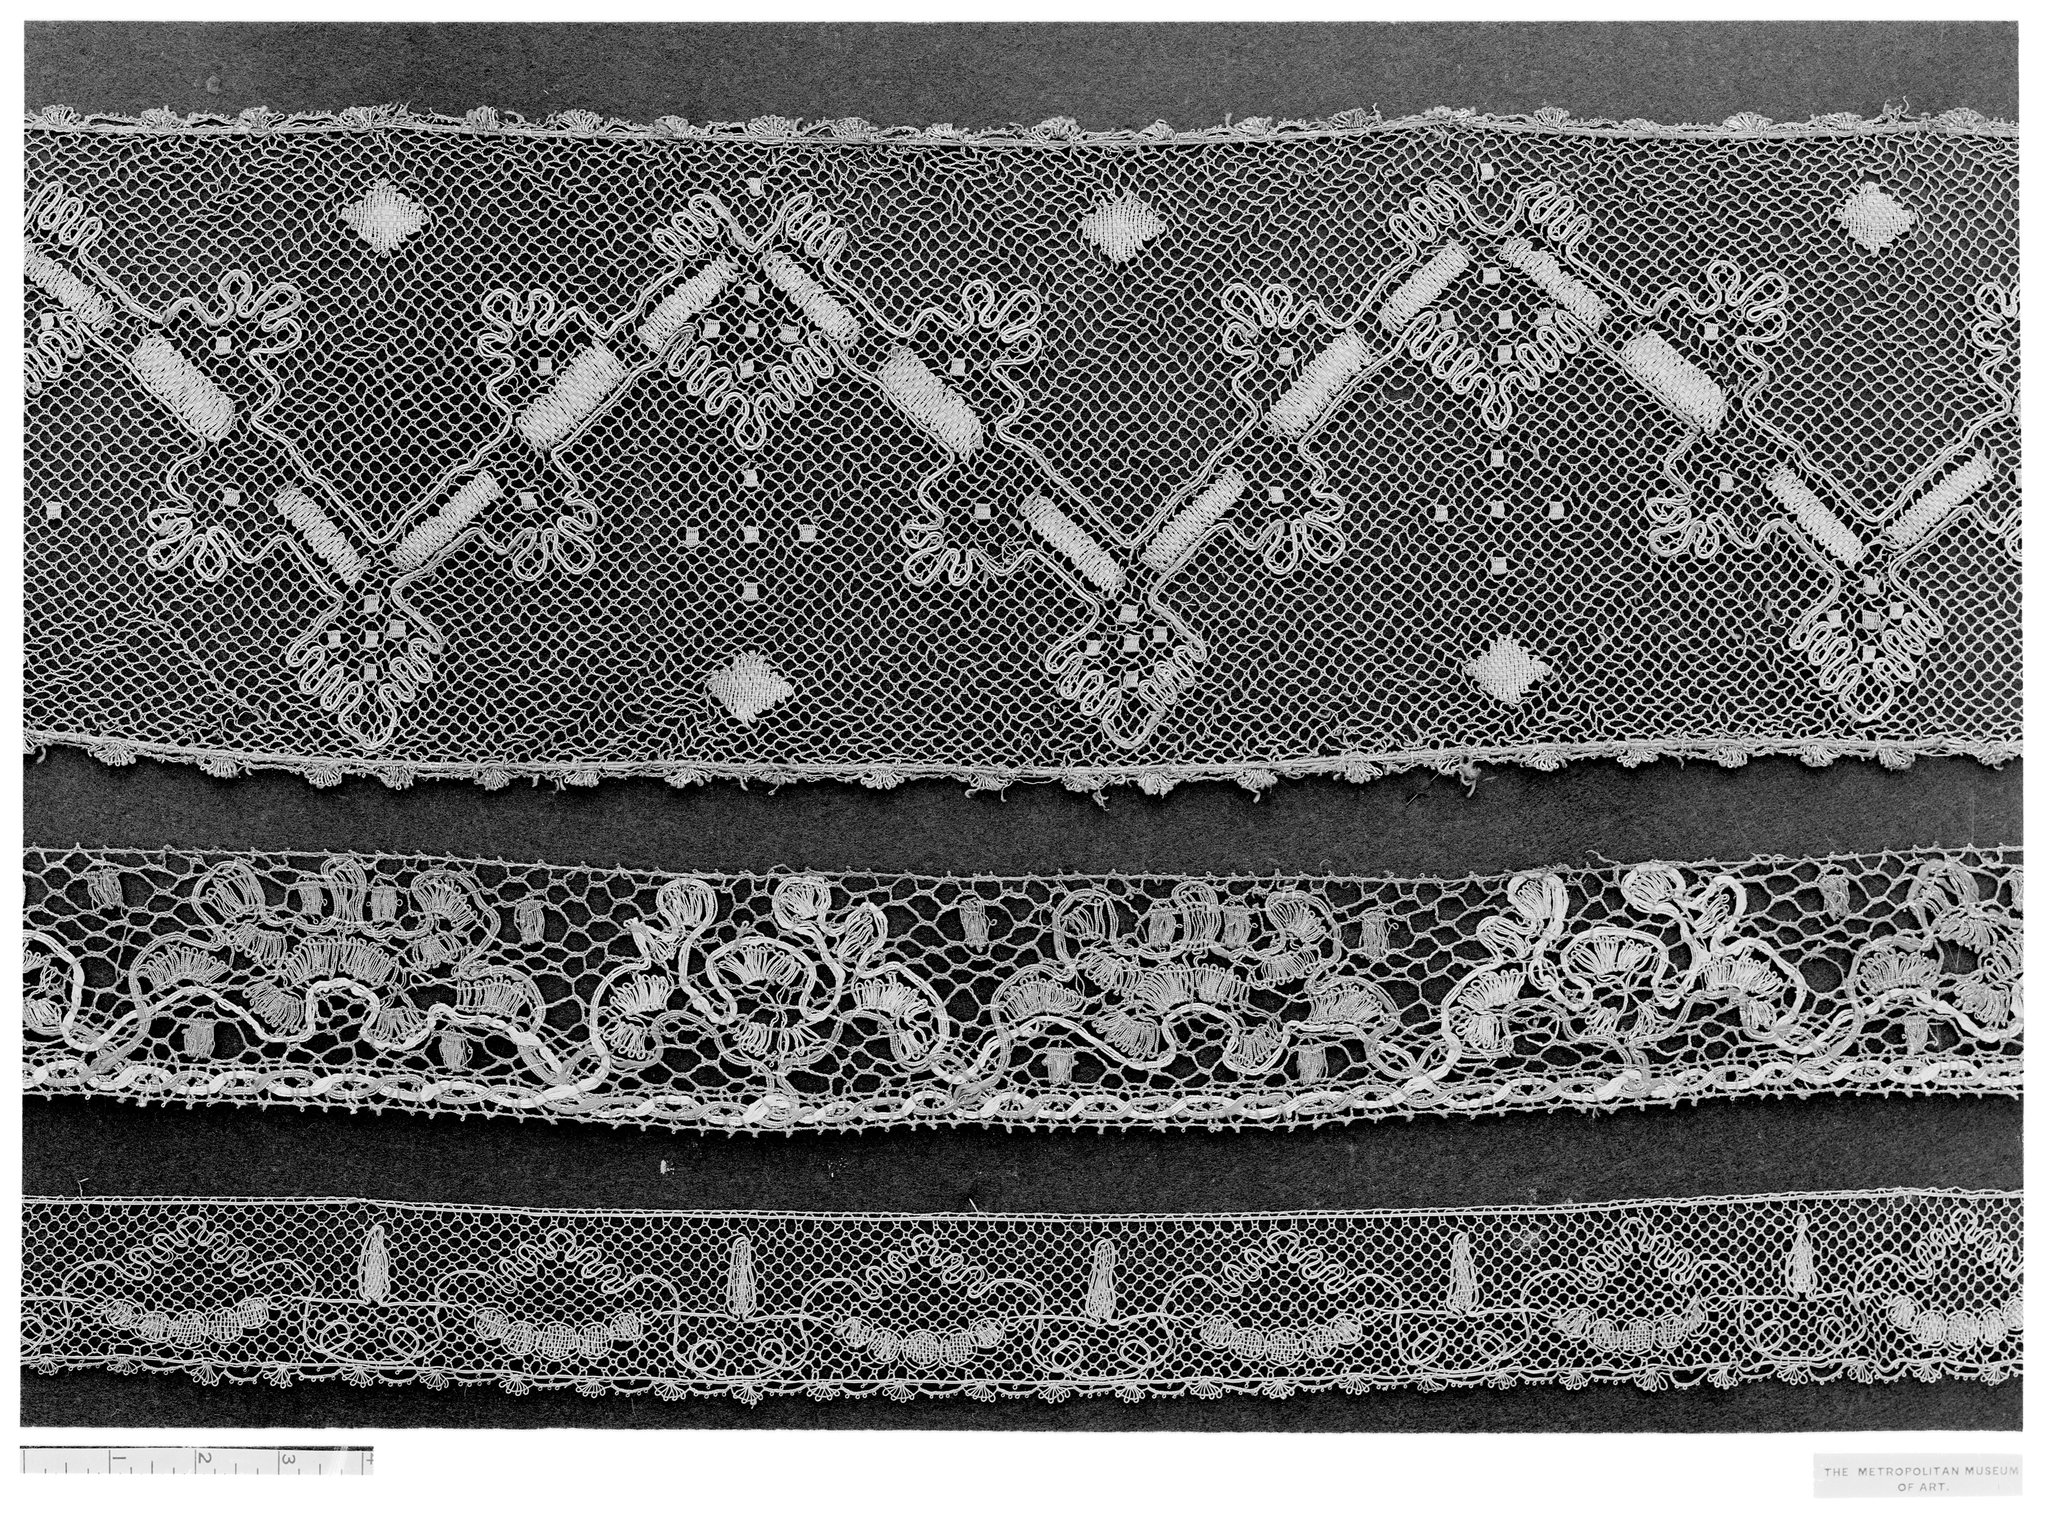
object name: fragment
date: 1634-1666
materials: metal thread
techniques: lace